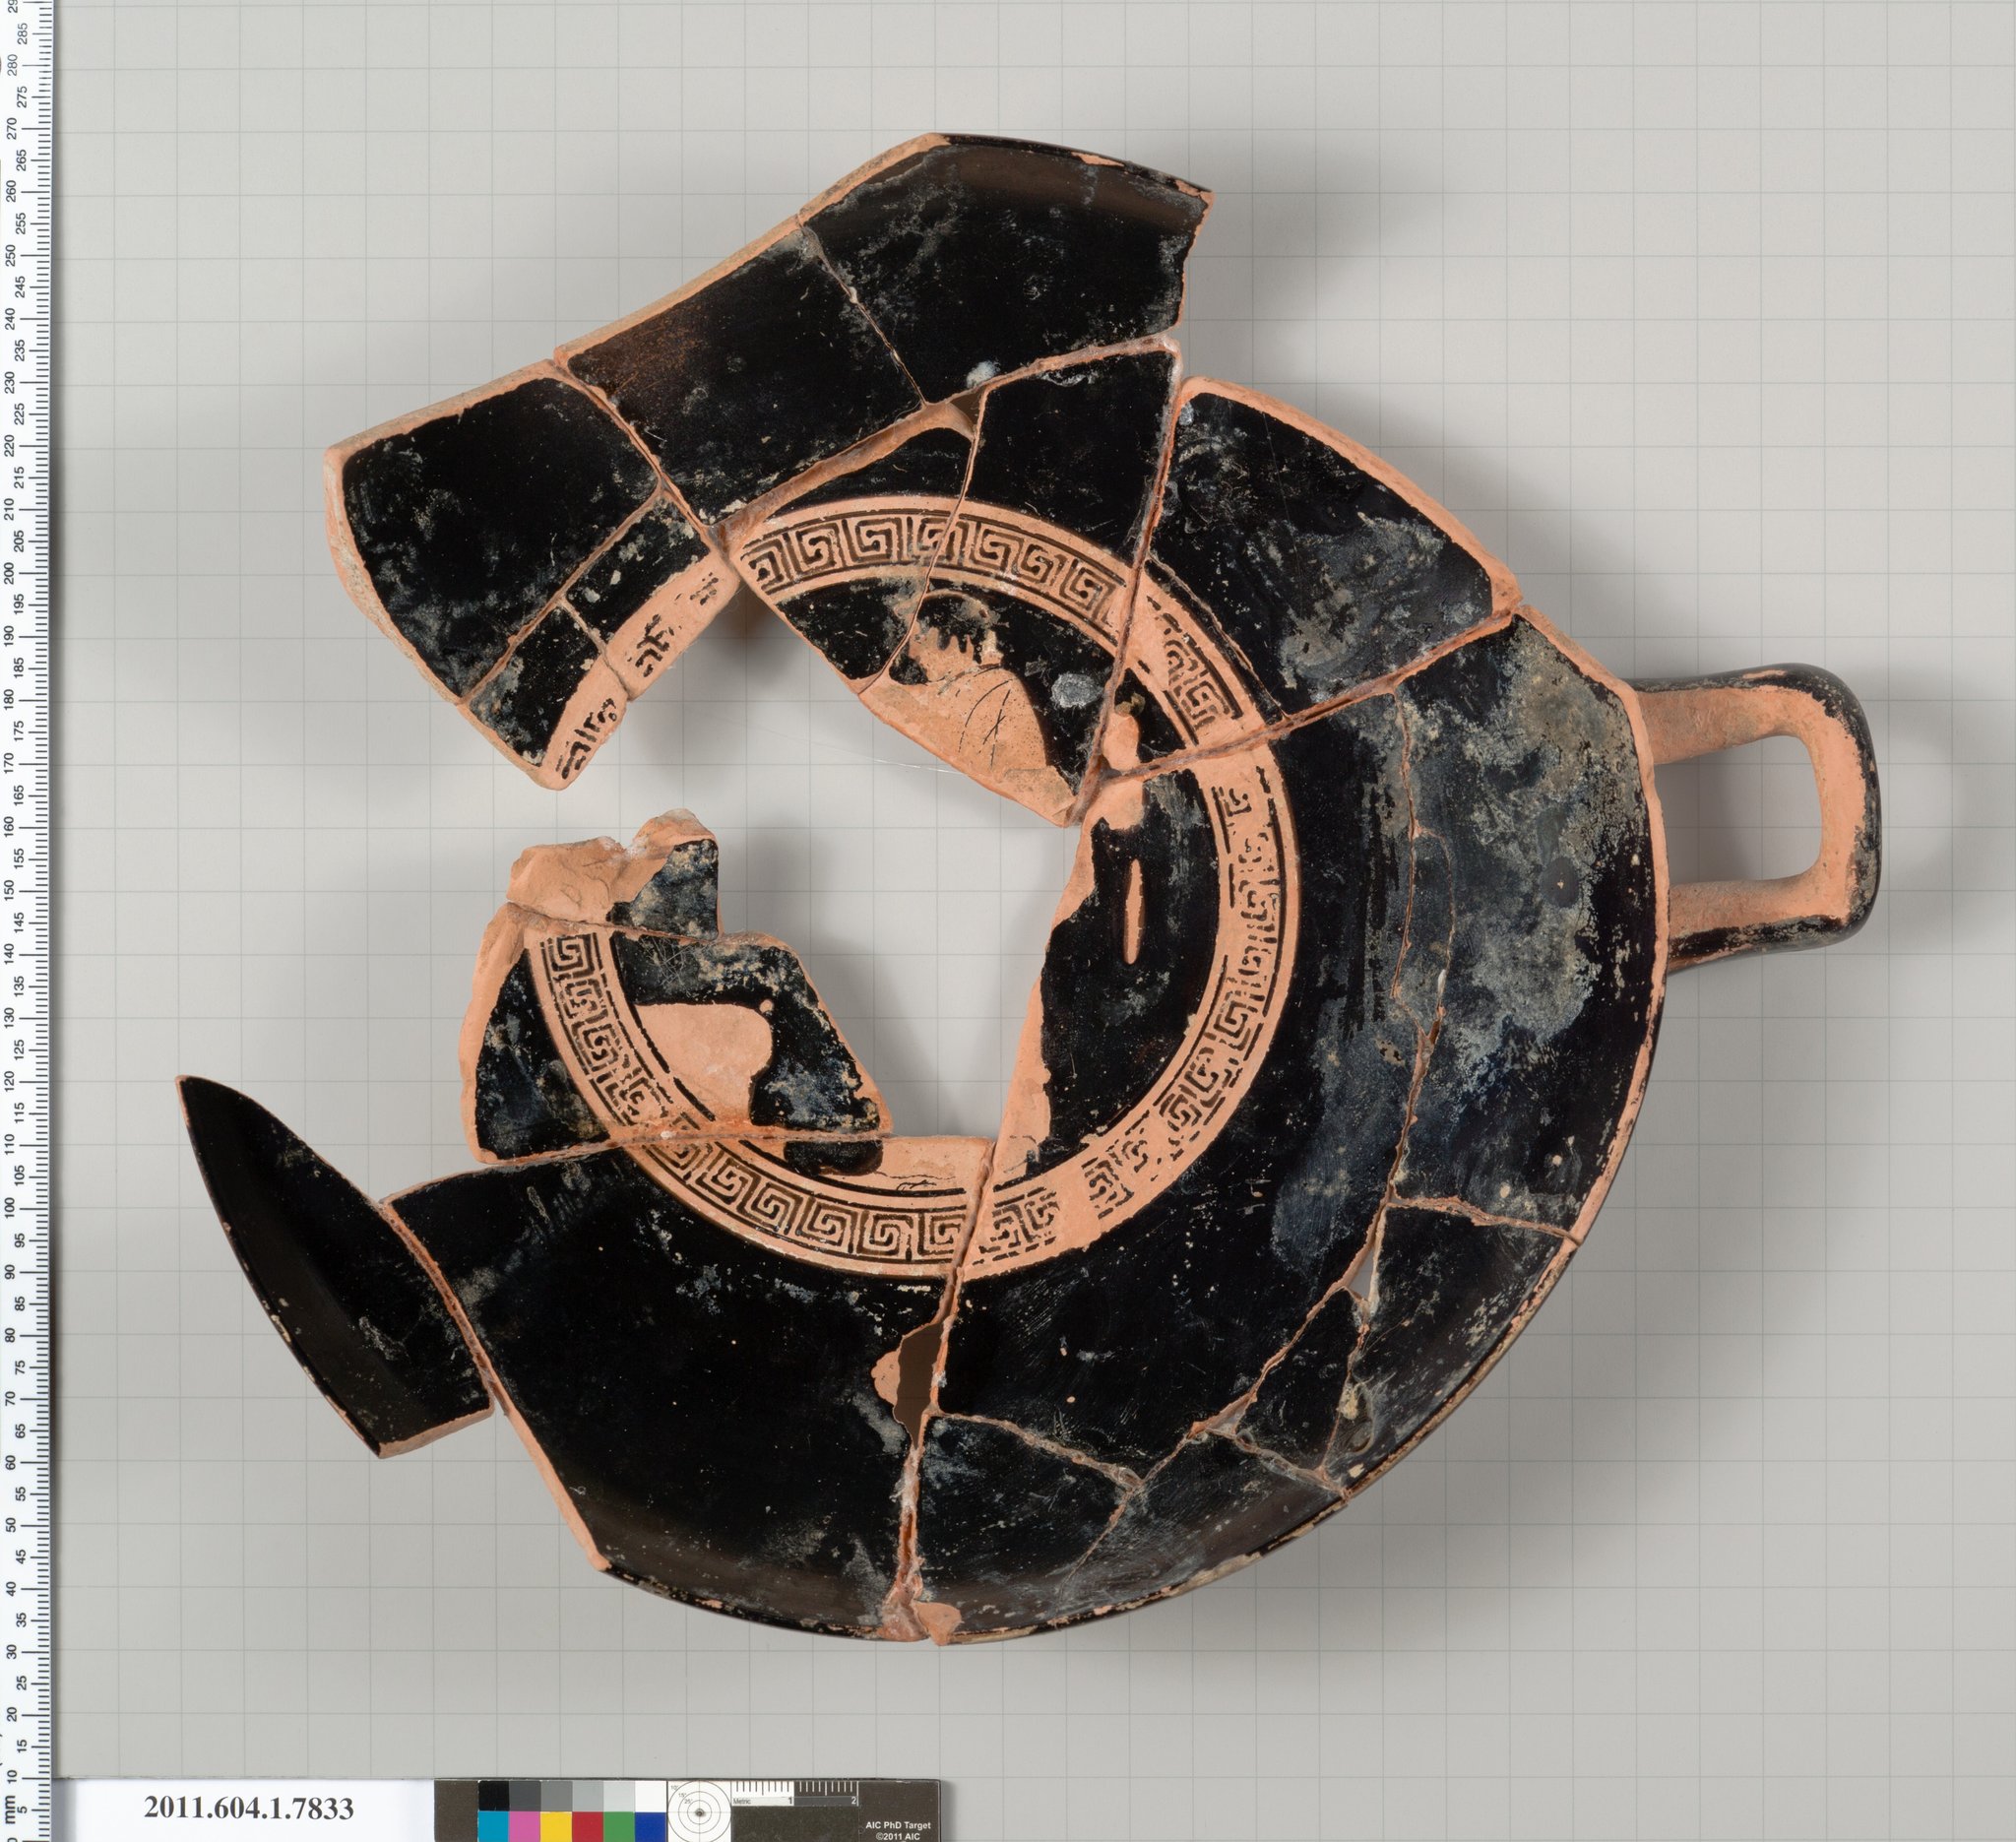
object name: kylix fragment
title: Terracotta fragment of a kylix (drinking cup)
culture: greek, attic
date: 460-450 BCE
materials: terracotta